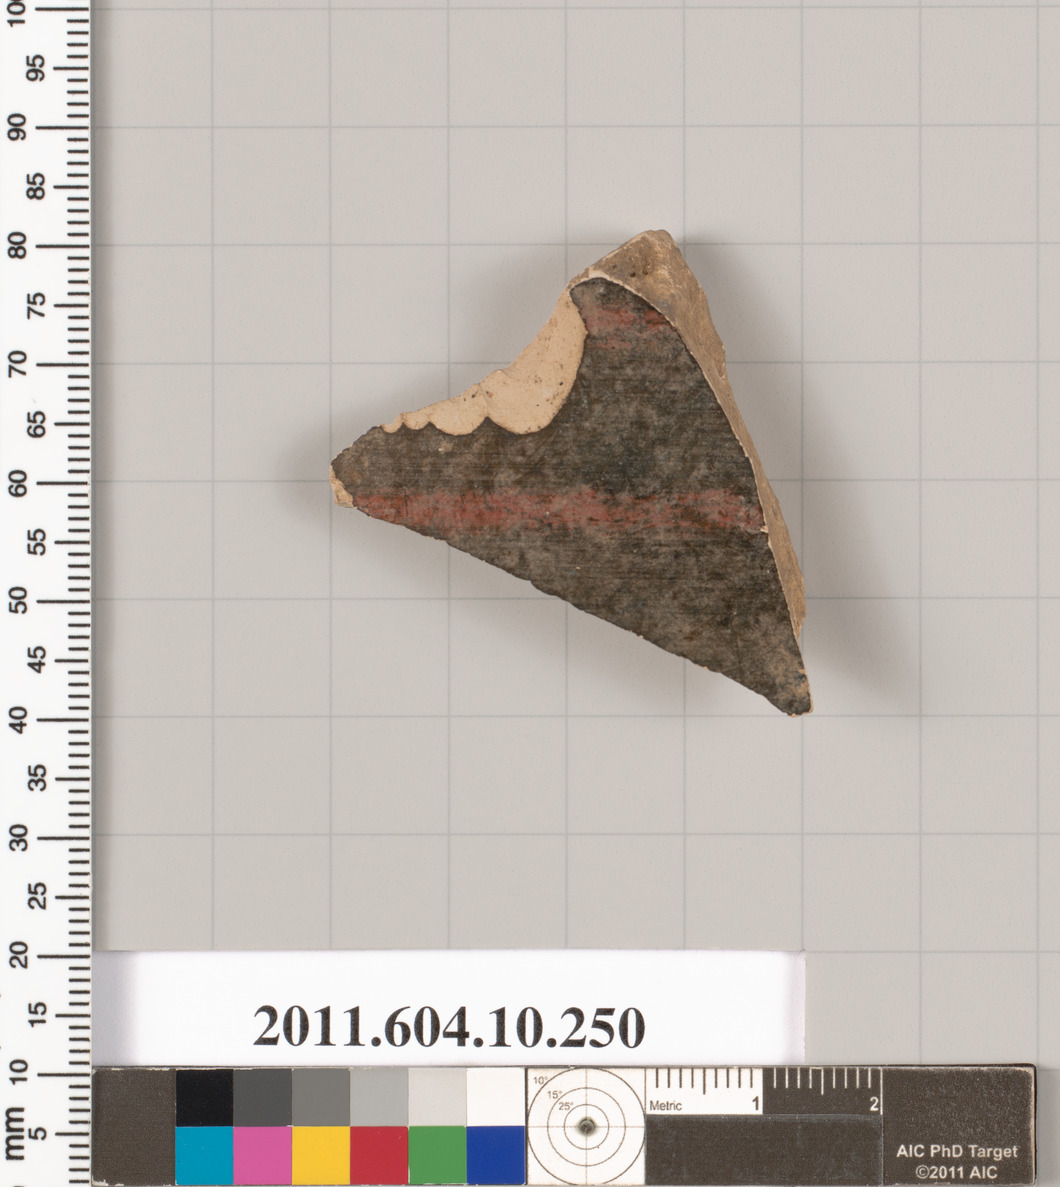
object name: undetermined closed shape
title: Terracotta fragment from a closed shape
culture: etruscan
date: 434-368 BCE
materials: terracotta